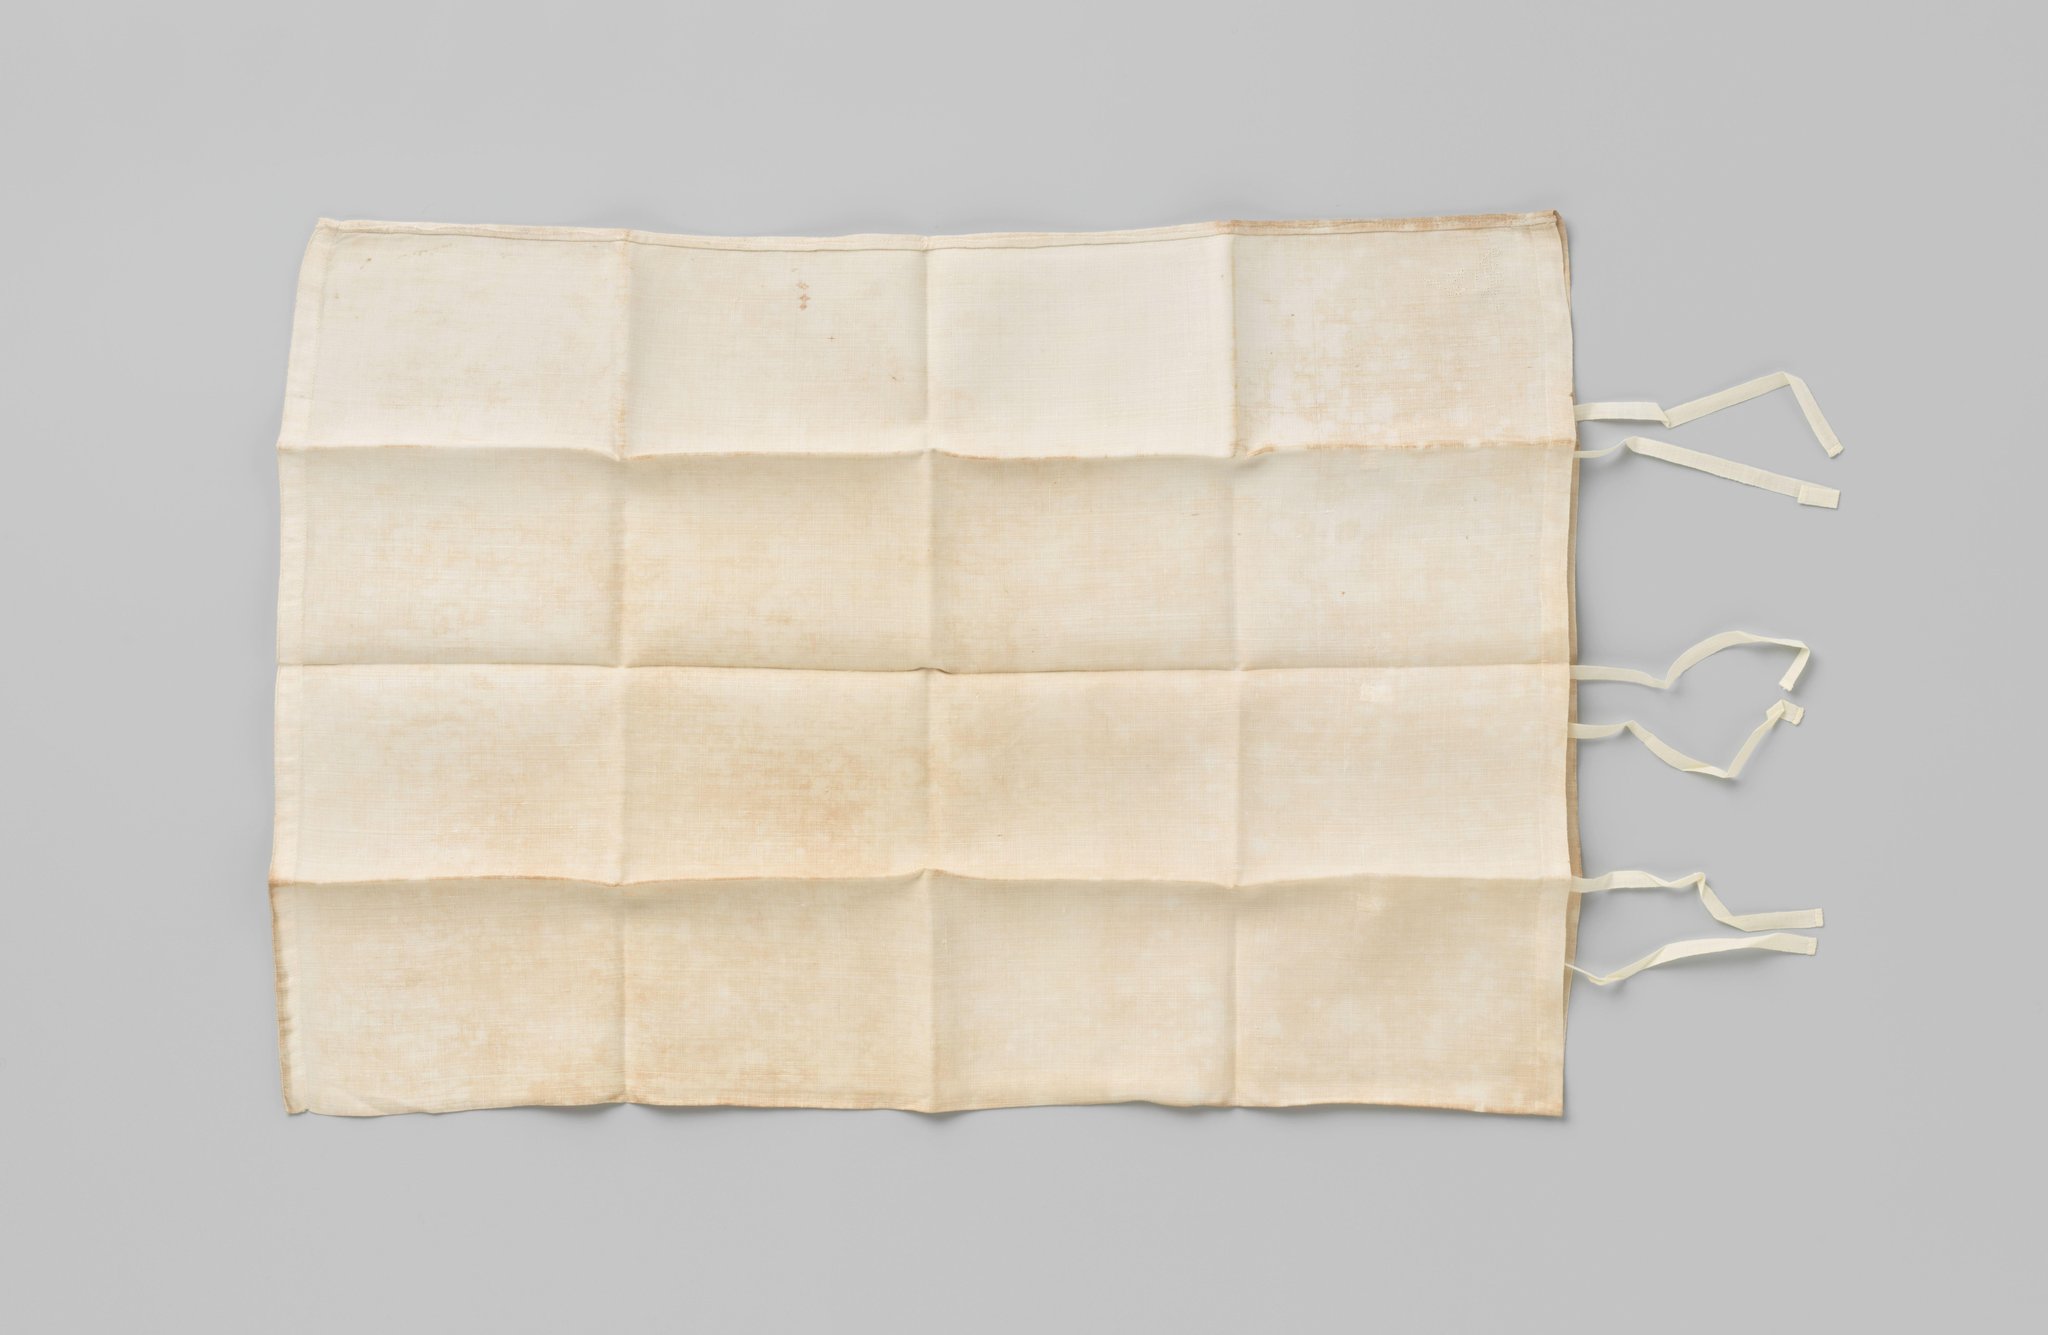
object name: lendensloop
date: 1716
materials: linen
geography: northern netherlands